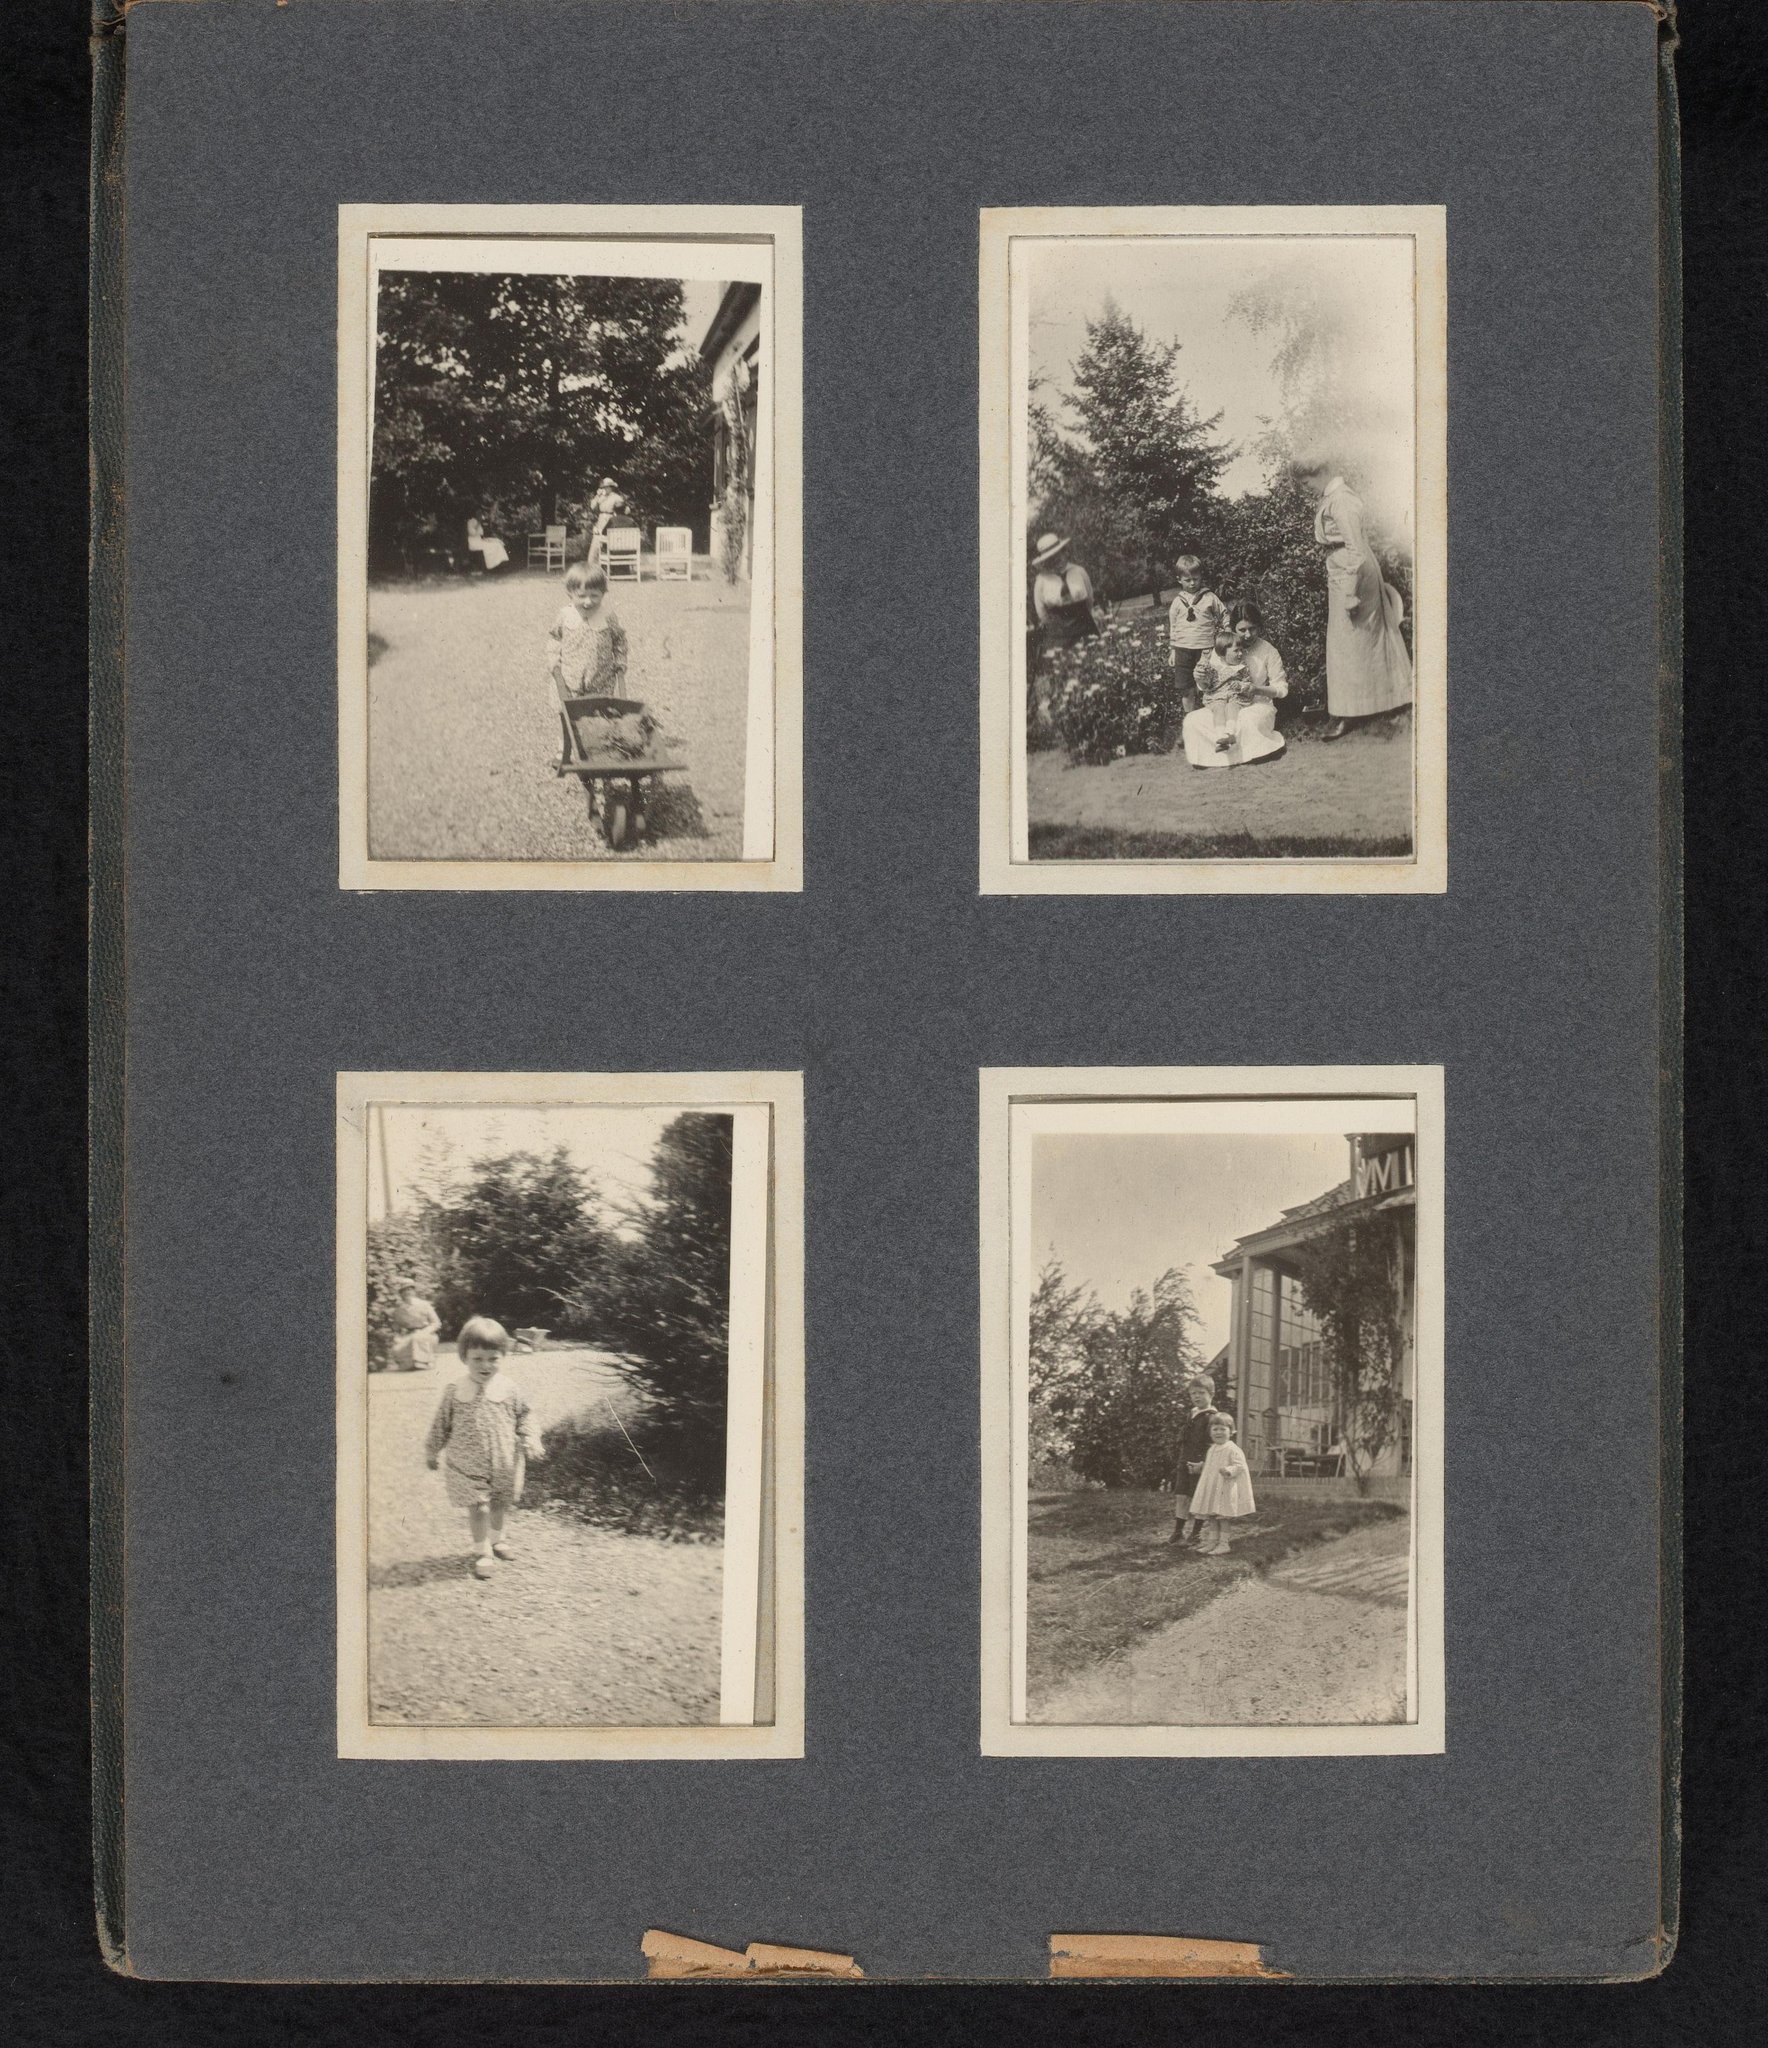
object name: photograph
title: Kinderen van de familie van den Berg in een tuin in Bergerac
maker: hendrik herman van den berg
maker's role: amateurfotograaf, jurist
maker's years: 1875-1944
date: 1907-1915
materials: paper, cardboard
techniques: gelatin silver print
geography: bergerac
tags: children's games and plays, family life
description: Deze foto's zijn onderdeel van een album.